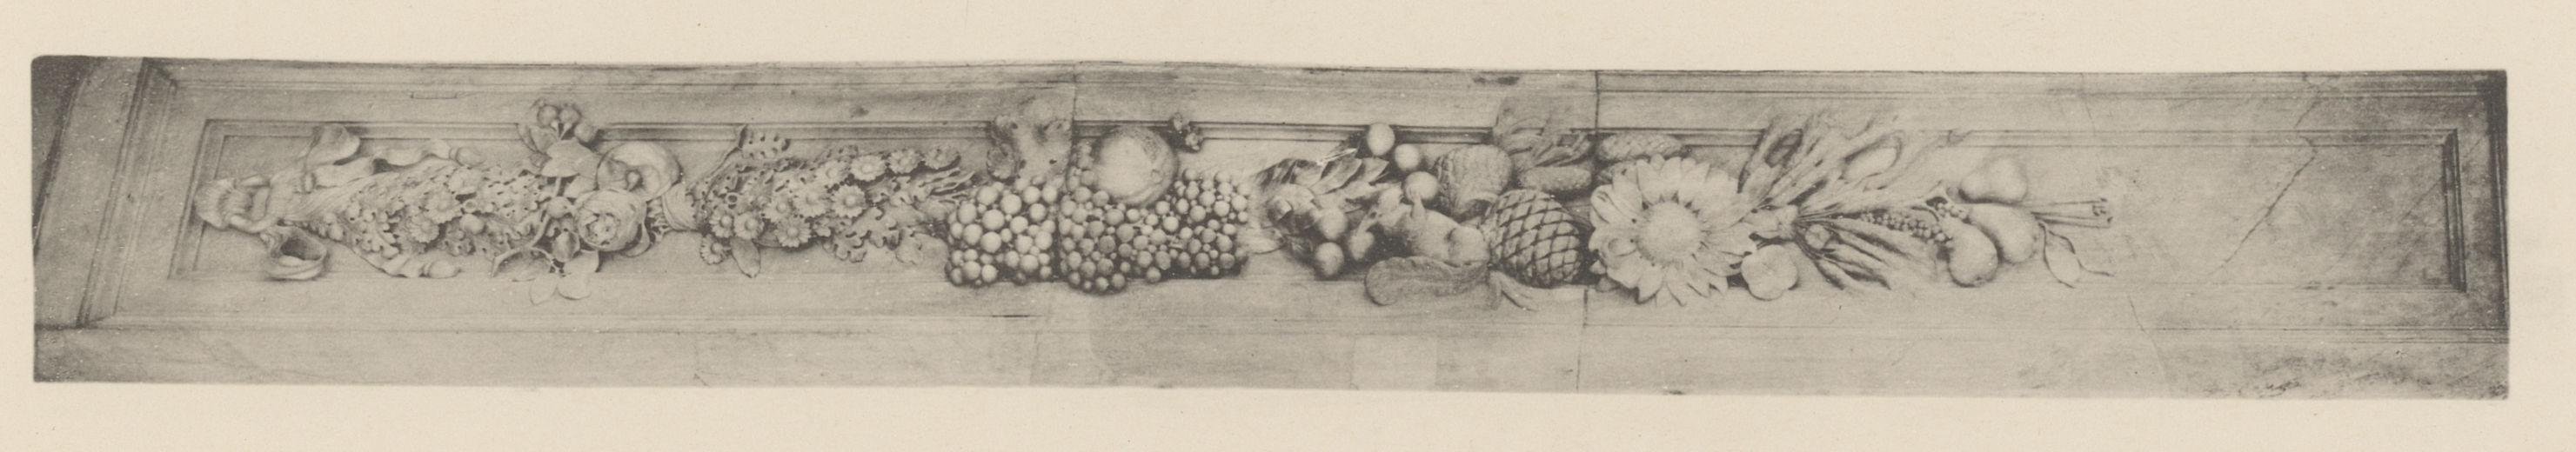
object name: fotomechanisch procedé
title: Ornamentele paneelvulling in de Burgerzaal, Paleis op de Dam, Amsterdam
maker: Anonymous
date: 1899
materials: cardboard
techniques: photograph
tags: palace, piece of sculpture, reproduction of a piece of sculpture, interior of the house, royal palace of amsterdam, amsterdam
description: Groote of Burgerzaal. Paneelvullingen in de doorgangen naar de Galerij.